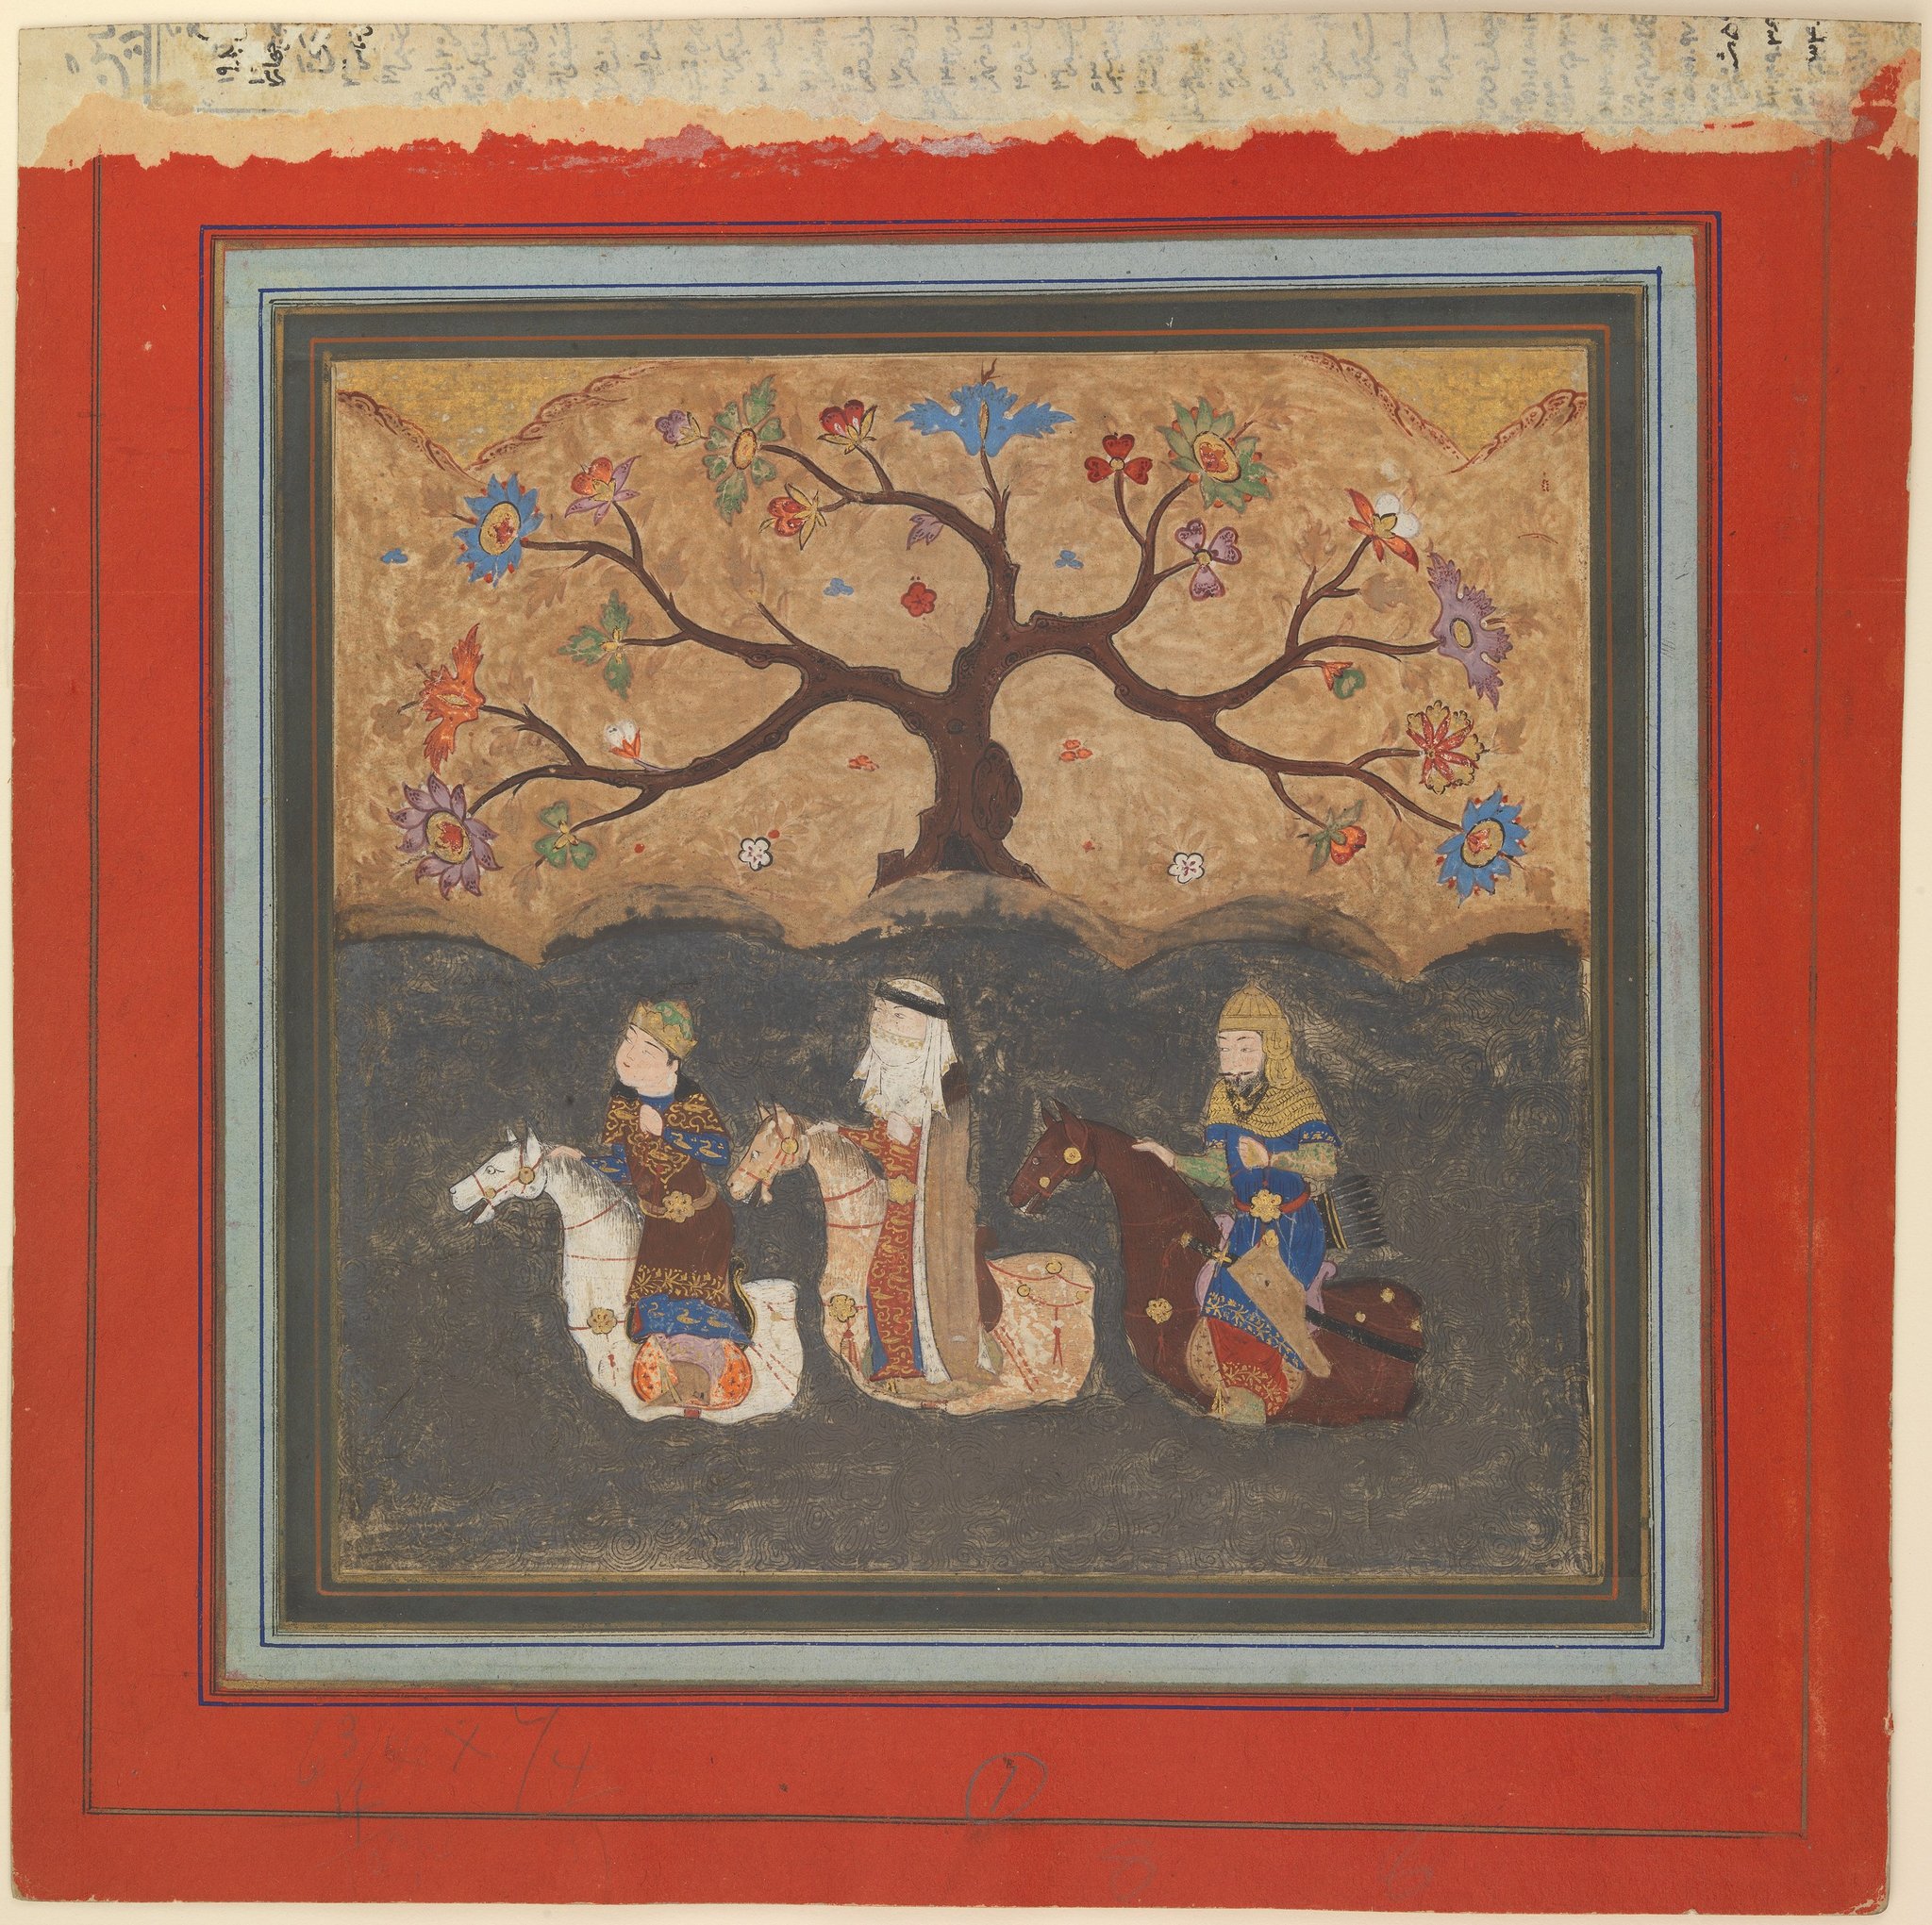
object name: folio from an illustrated manuscript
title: "Kai Khusrau, Farangis and Giv Crossing the River Jihun (Oxus)", Folio from a Shahnama (Book of Kings)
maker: abu'l qasim firdausi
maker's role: author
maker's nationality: iranian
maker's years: 935-1020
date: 1434-1466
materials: gold, ink, paper, silver, watercolor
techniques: dyeing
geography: india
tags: kings,men,women,horses,rivers